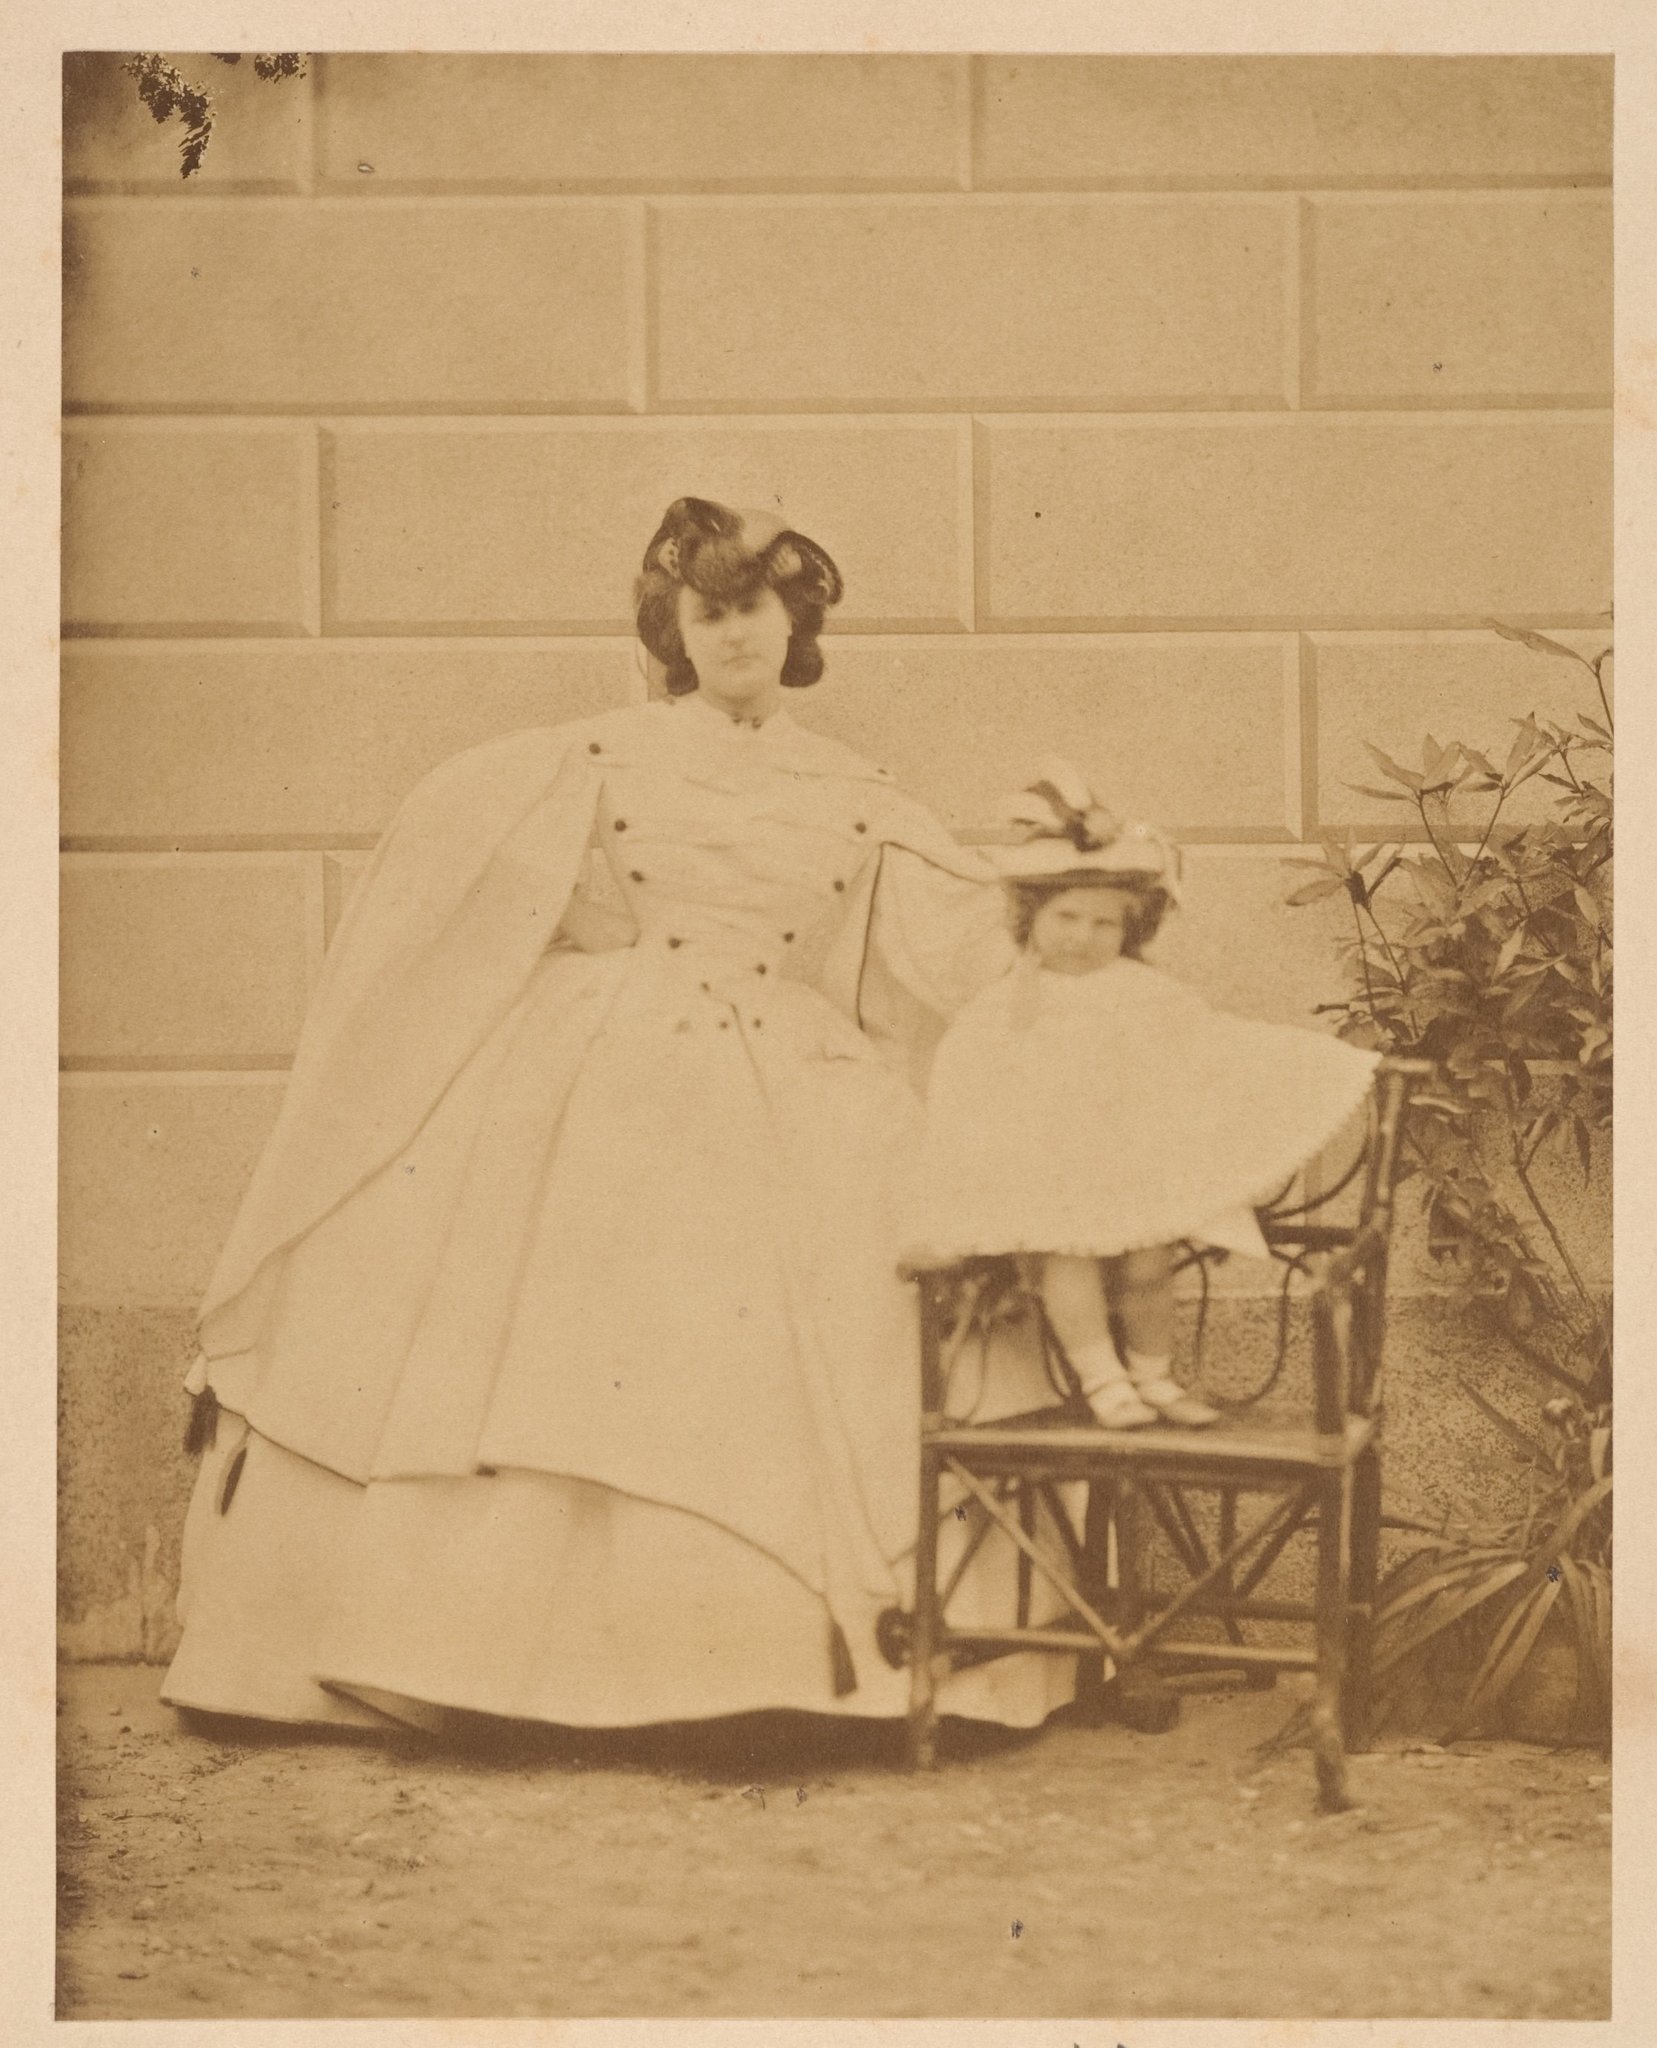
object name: photograph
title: La Mere et L'Epoux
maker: pierre-louis pierson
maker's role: artist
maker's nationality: french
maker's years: 1822-1913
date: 1860-1869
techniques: albumen silver print, glass negative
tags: girls,portraits,mothers,women